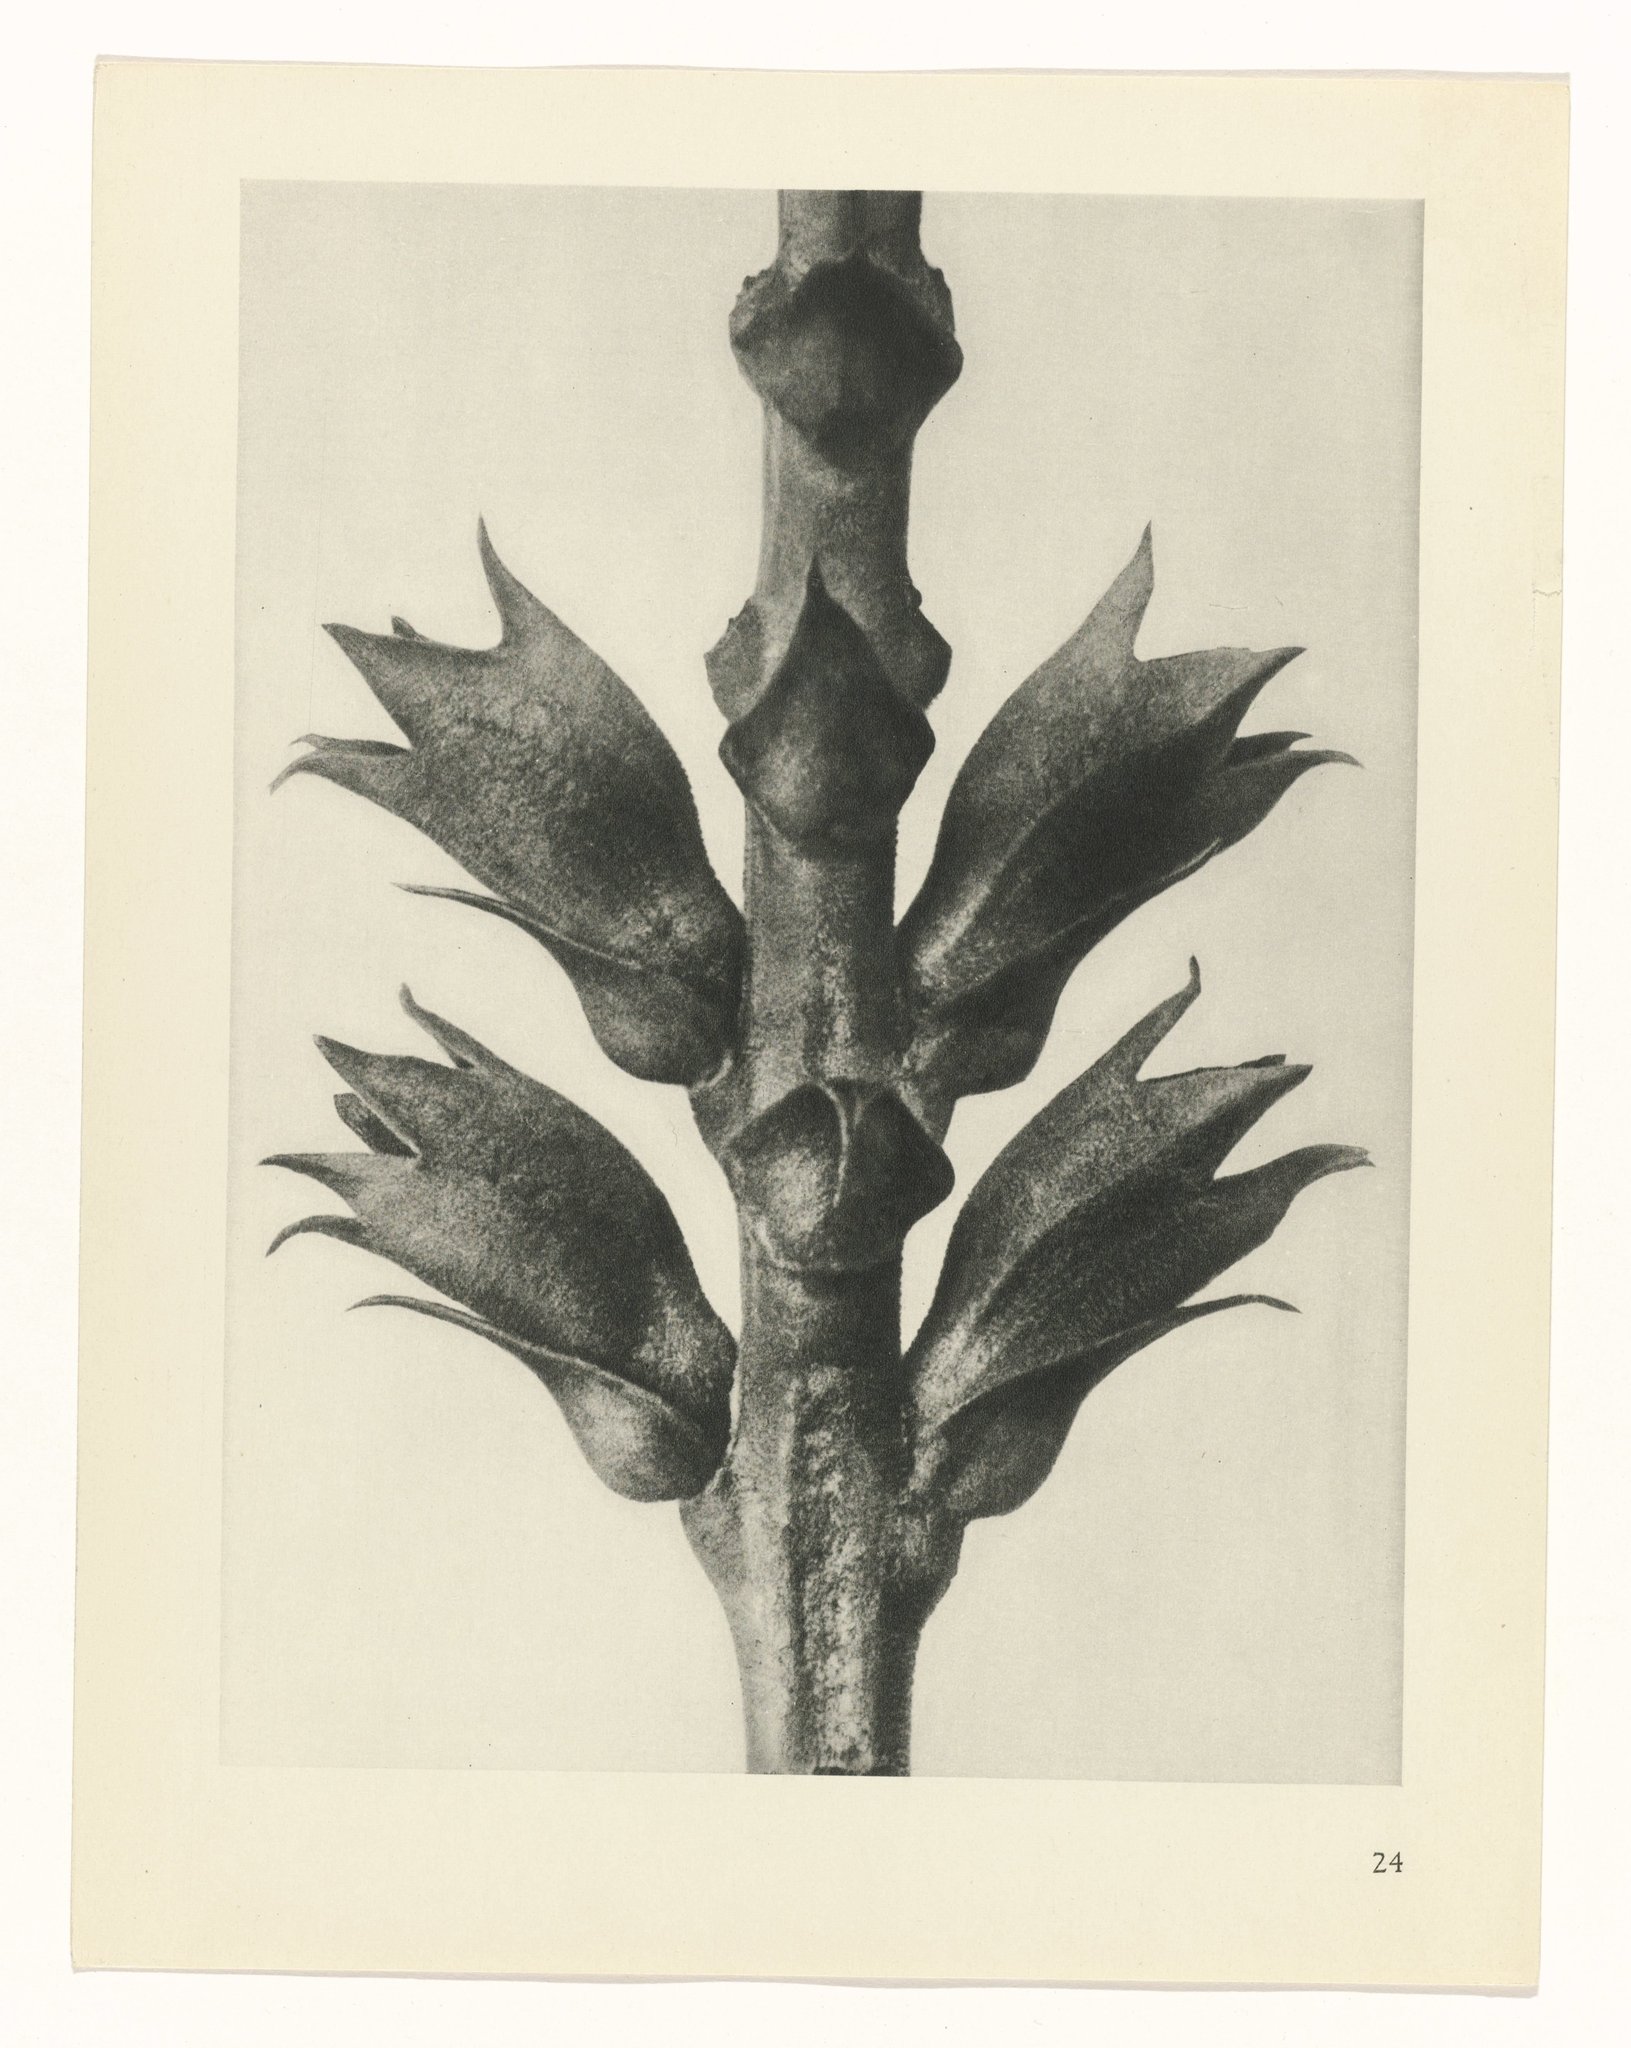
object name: photograph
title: Plantstudie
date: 1928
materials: ink, paper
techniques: rotogravure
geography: berlin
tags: plants (in general)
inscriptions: number: ‘24’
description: facher Vergrößerung. Afkomstig uit losbladige uitgave.